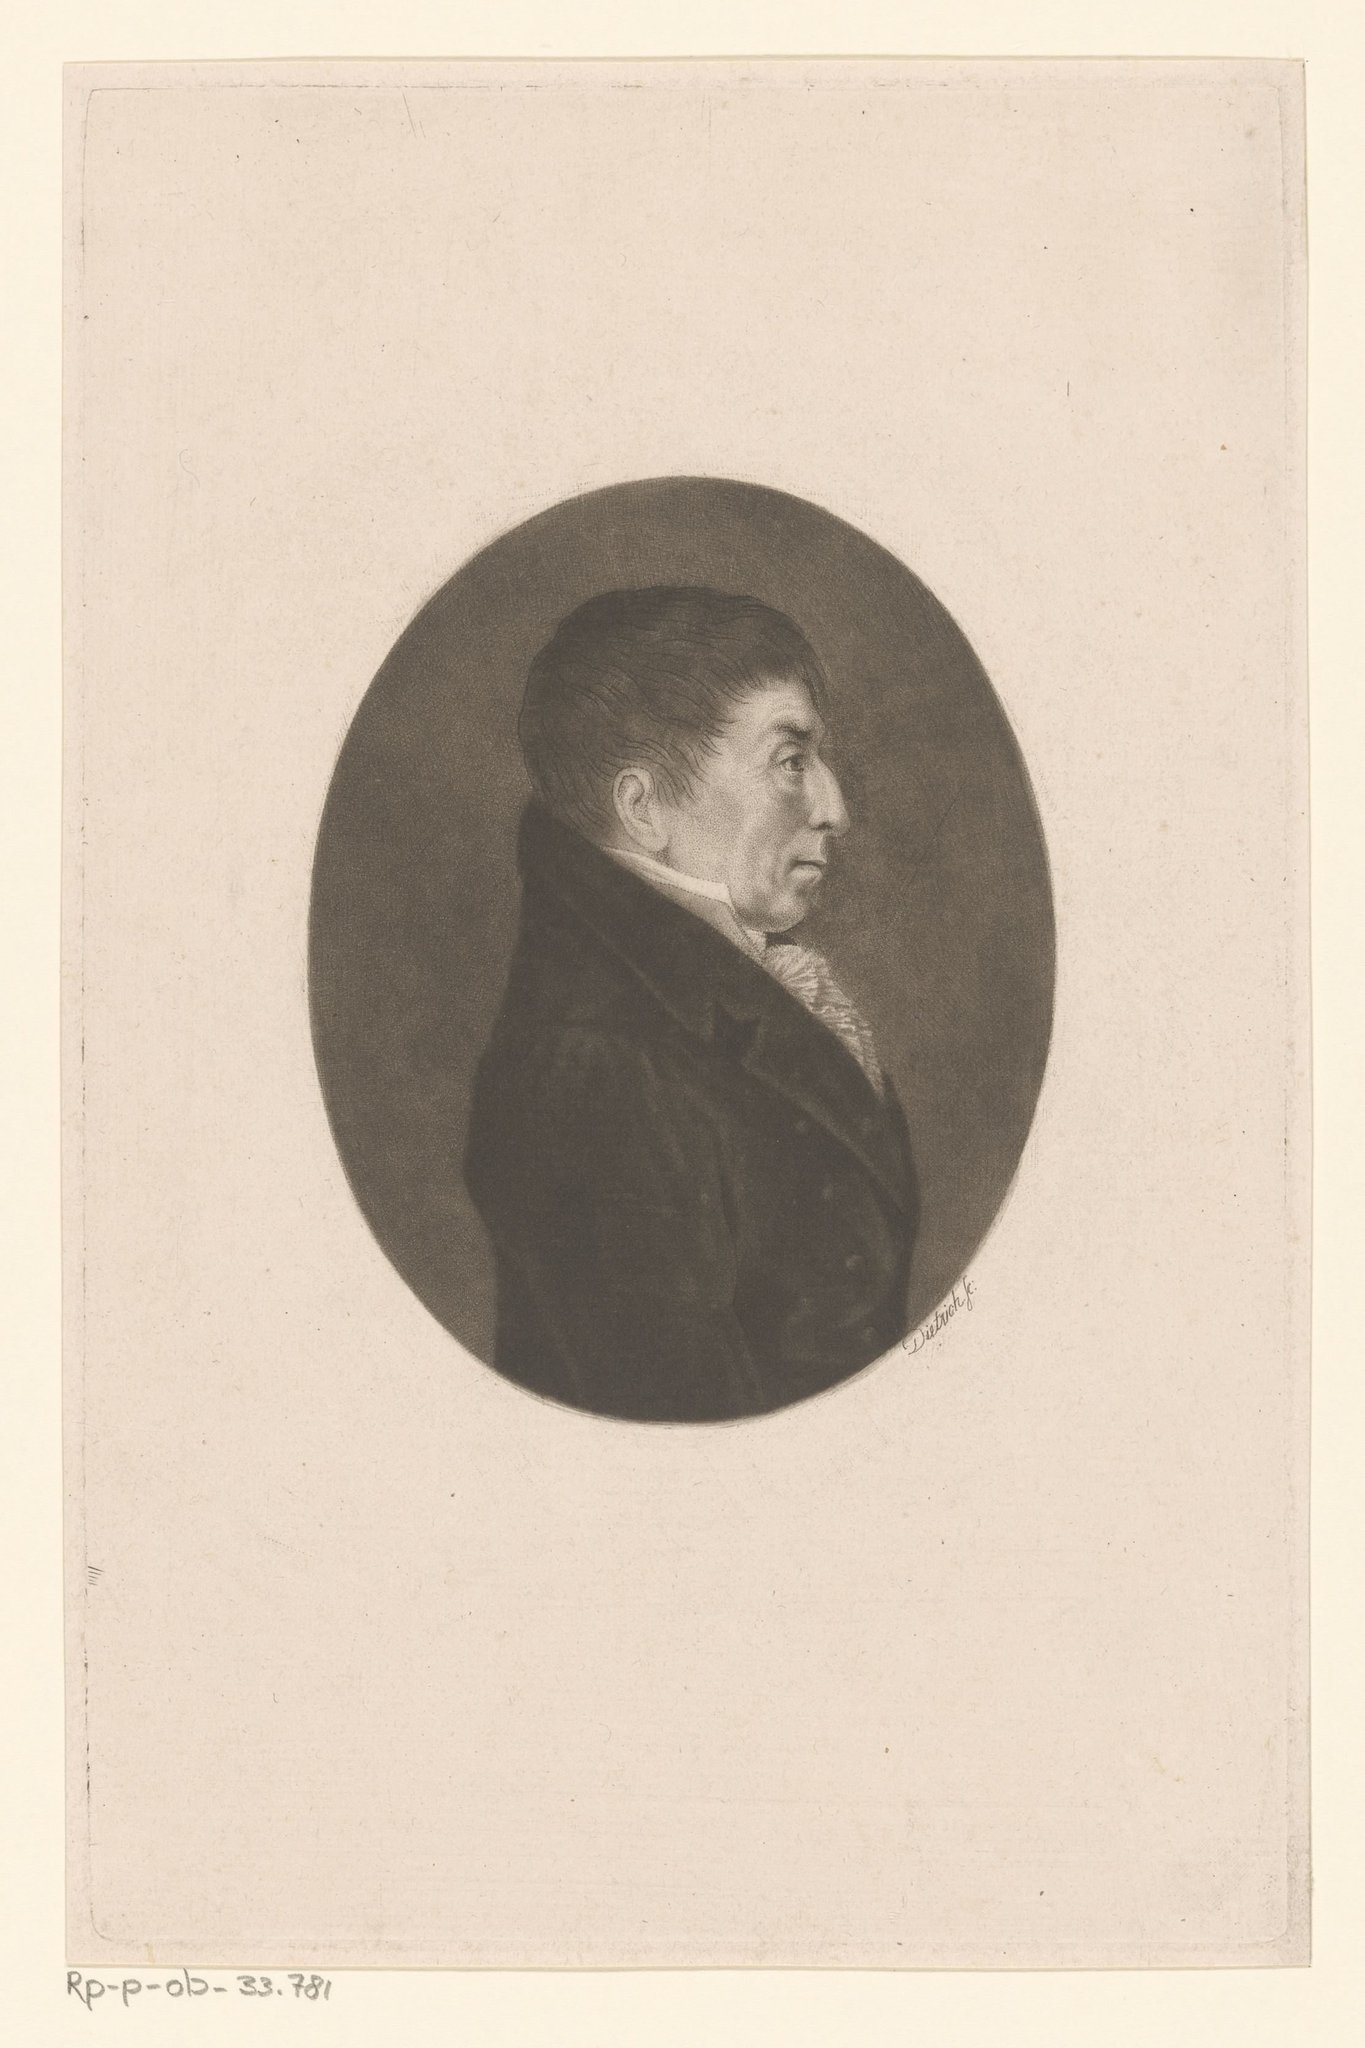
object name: print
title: Portret van een onbekende man, mogelijk J.C. Krauss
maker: friedrich christoph dietrich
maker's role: print maker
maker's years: 1779-1847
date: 1789-1847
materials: paper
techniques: etching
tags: historical persons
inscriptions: collector's mark: Lugt 2228